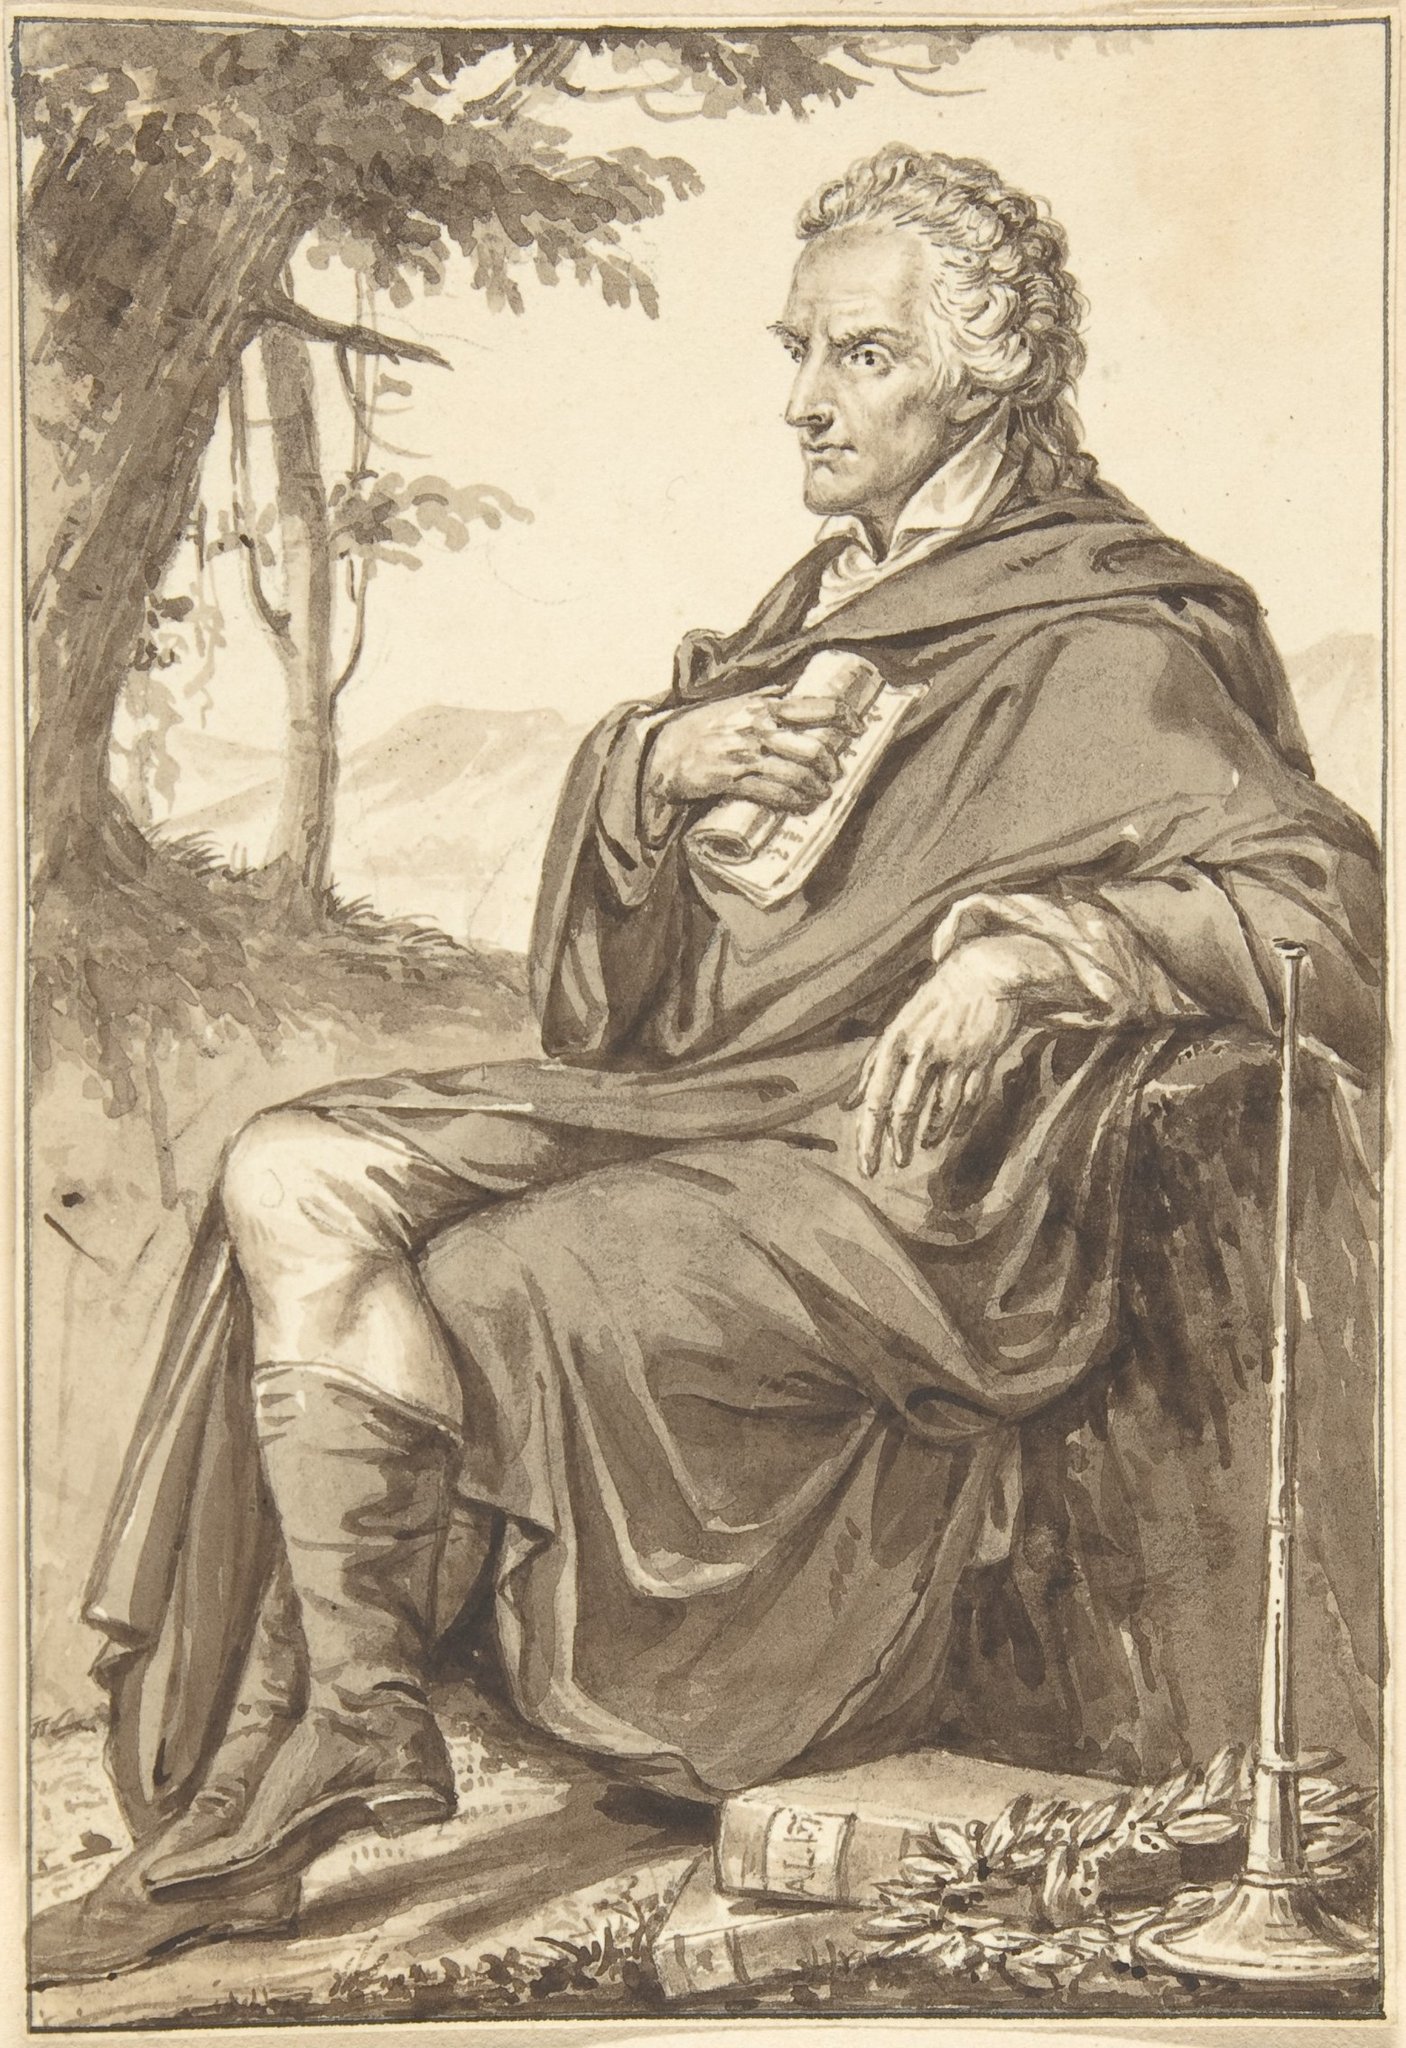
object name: drawing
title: Portrait of Count Vittorio Alfieri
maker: jean-baptiste-françois bosio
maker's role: artist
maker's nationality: french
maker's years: 1764-1827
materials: graphite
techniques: brush, wash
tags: men,portraits